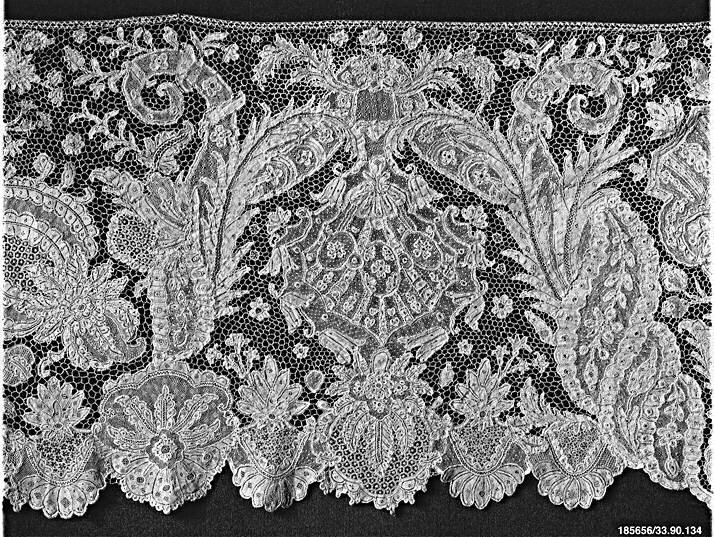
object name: flounce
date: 1701-1733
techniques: lace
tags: flowers